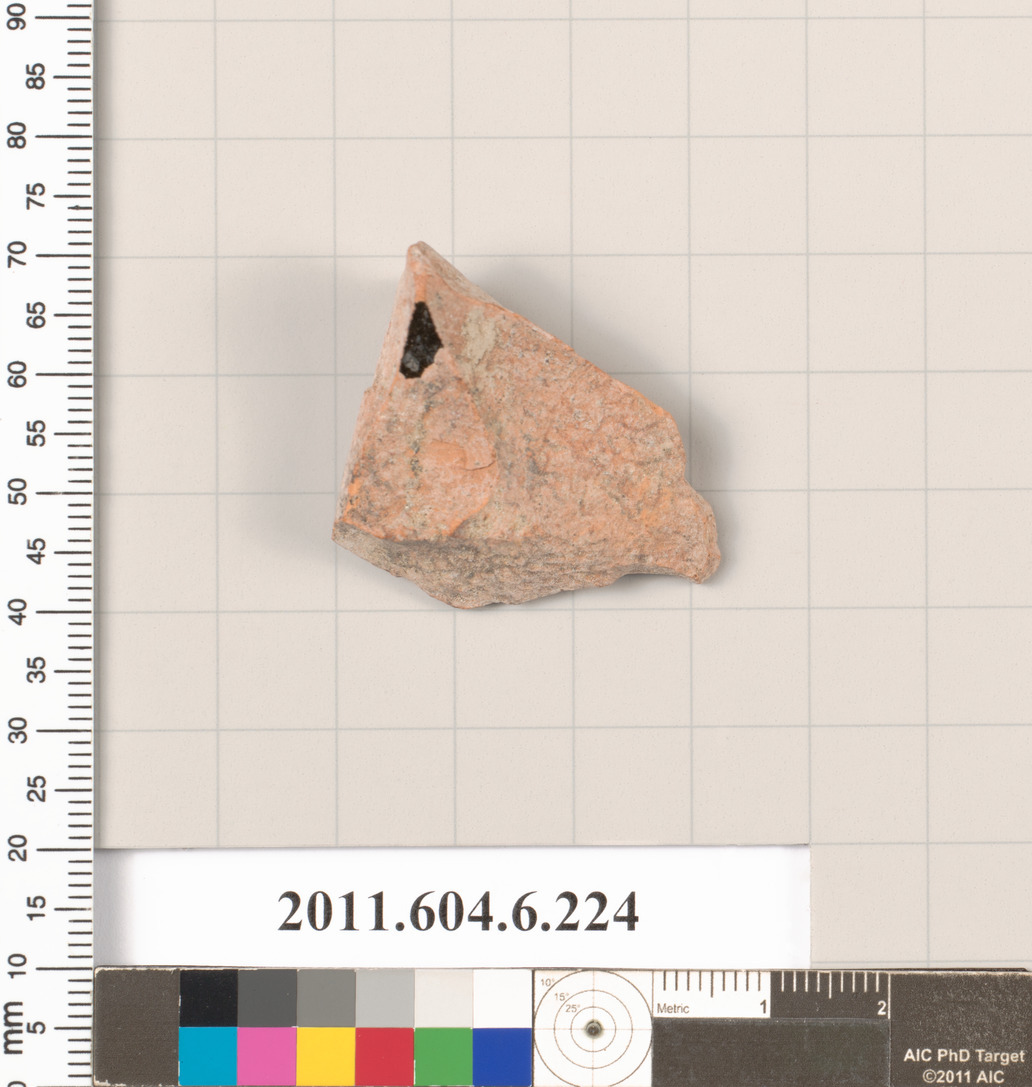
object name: undetermined open shape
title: Terracotta fragment of an open shape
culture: greek, attic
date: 600-401 BCE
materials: terracotta